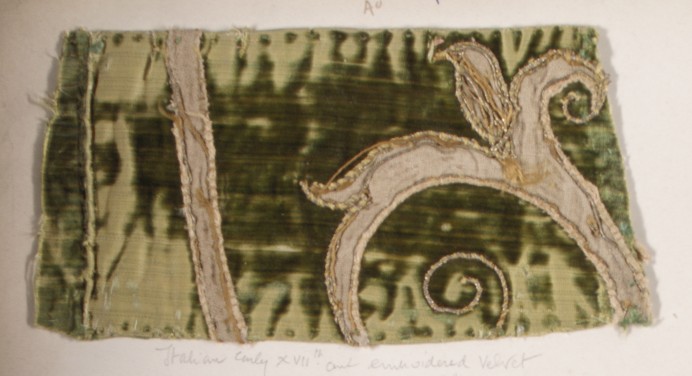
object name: fragment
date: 1601-1633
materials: metal thread, silk